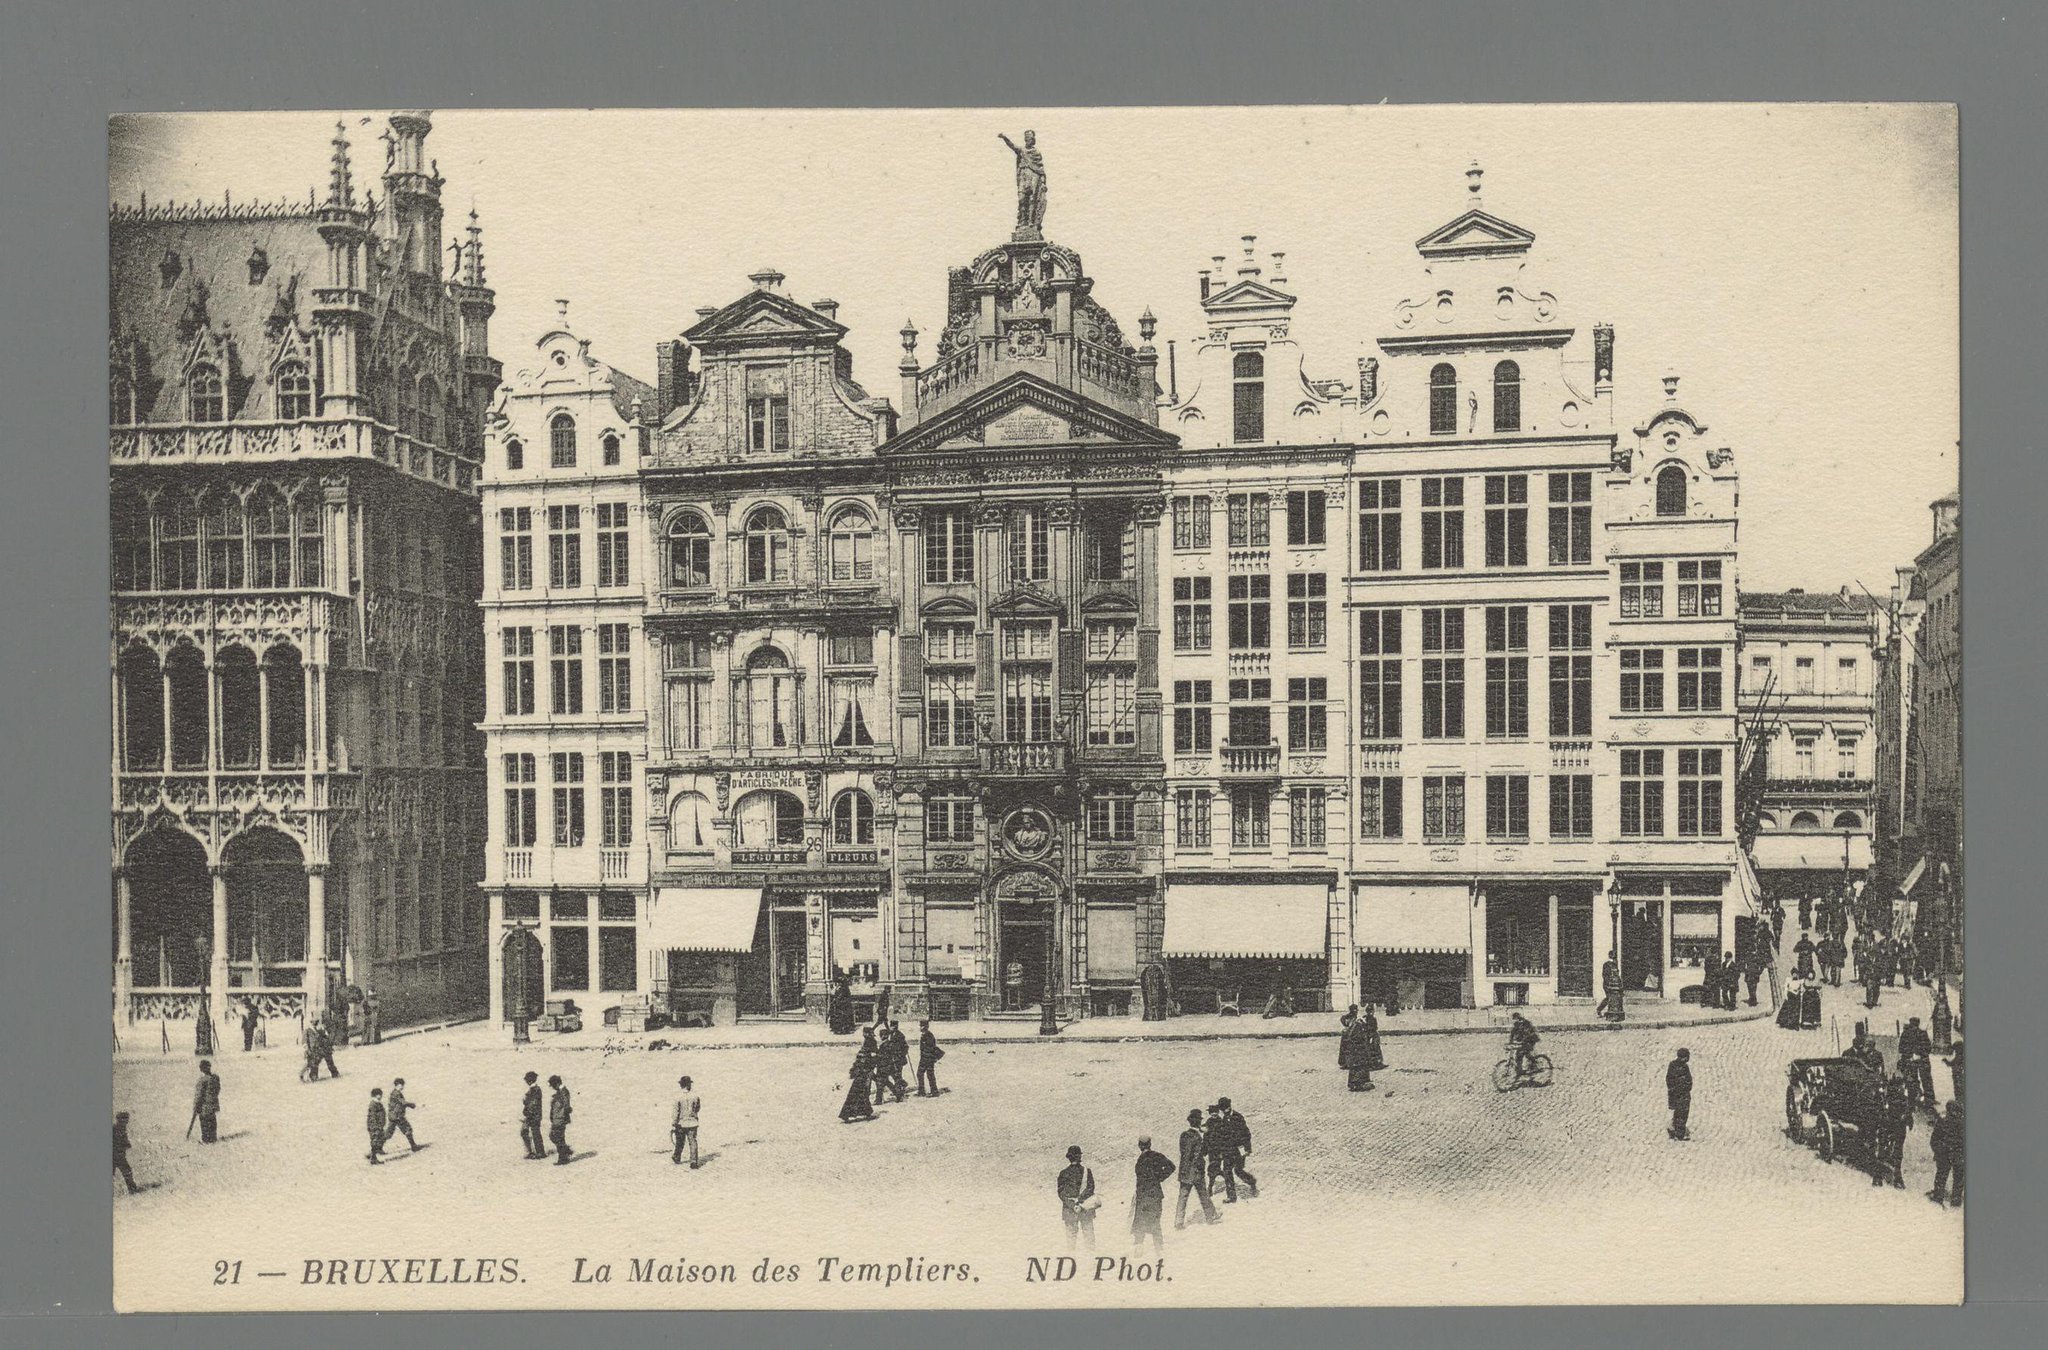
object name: photomechanical print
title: Bruxelles. La Maison des Templiers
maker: Anonymous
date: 1906-1918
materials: cardboard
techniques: photograph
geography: paris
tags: urban housing, city-view, and landscape with man-made constructions (+ city(-scape) with figures, staffage)